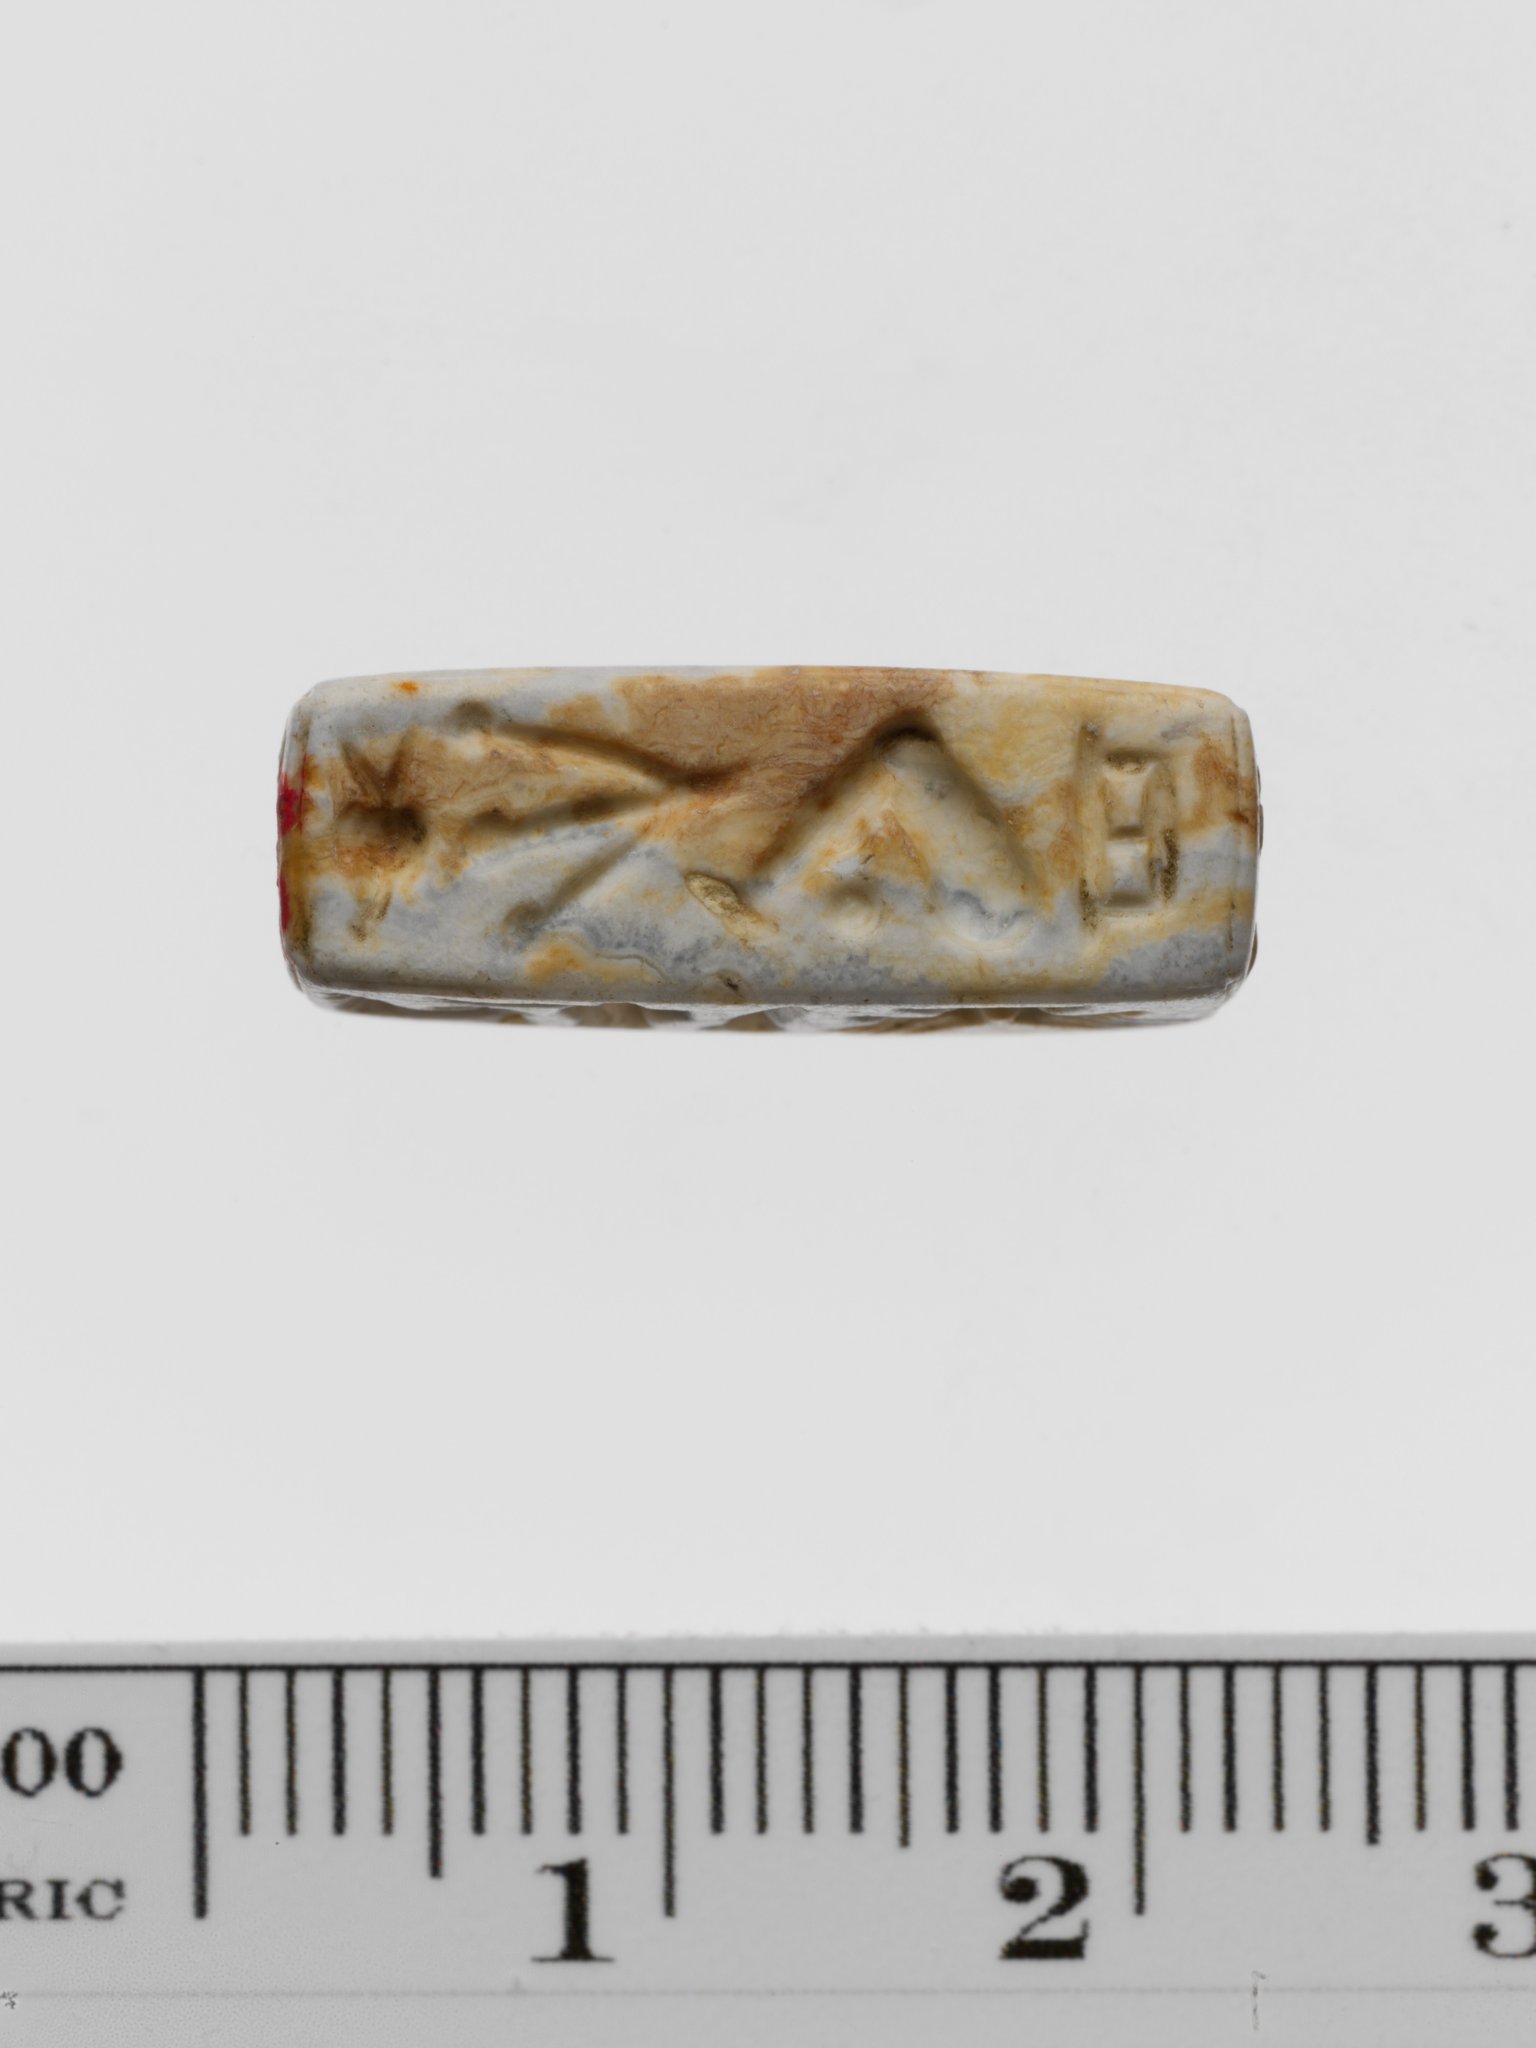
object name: seal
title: Chalcedony rectangular prism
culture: minoan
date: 1750-1600 BCE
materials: stone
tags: hieroglyphs